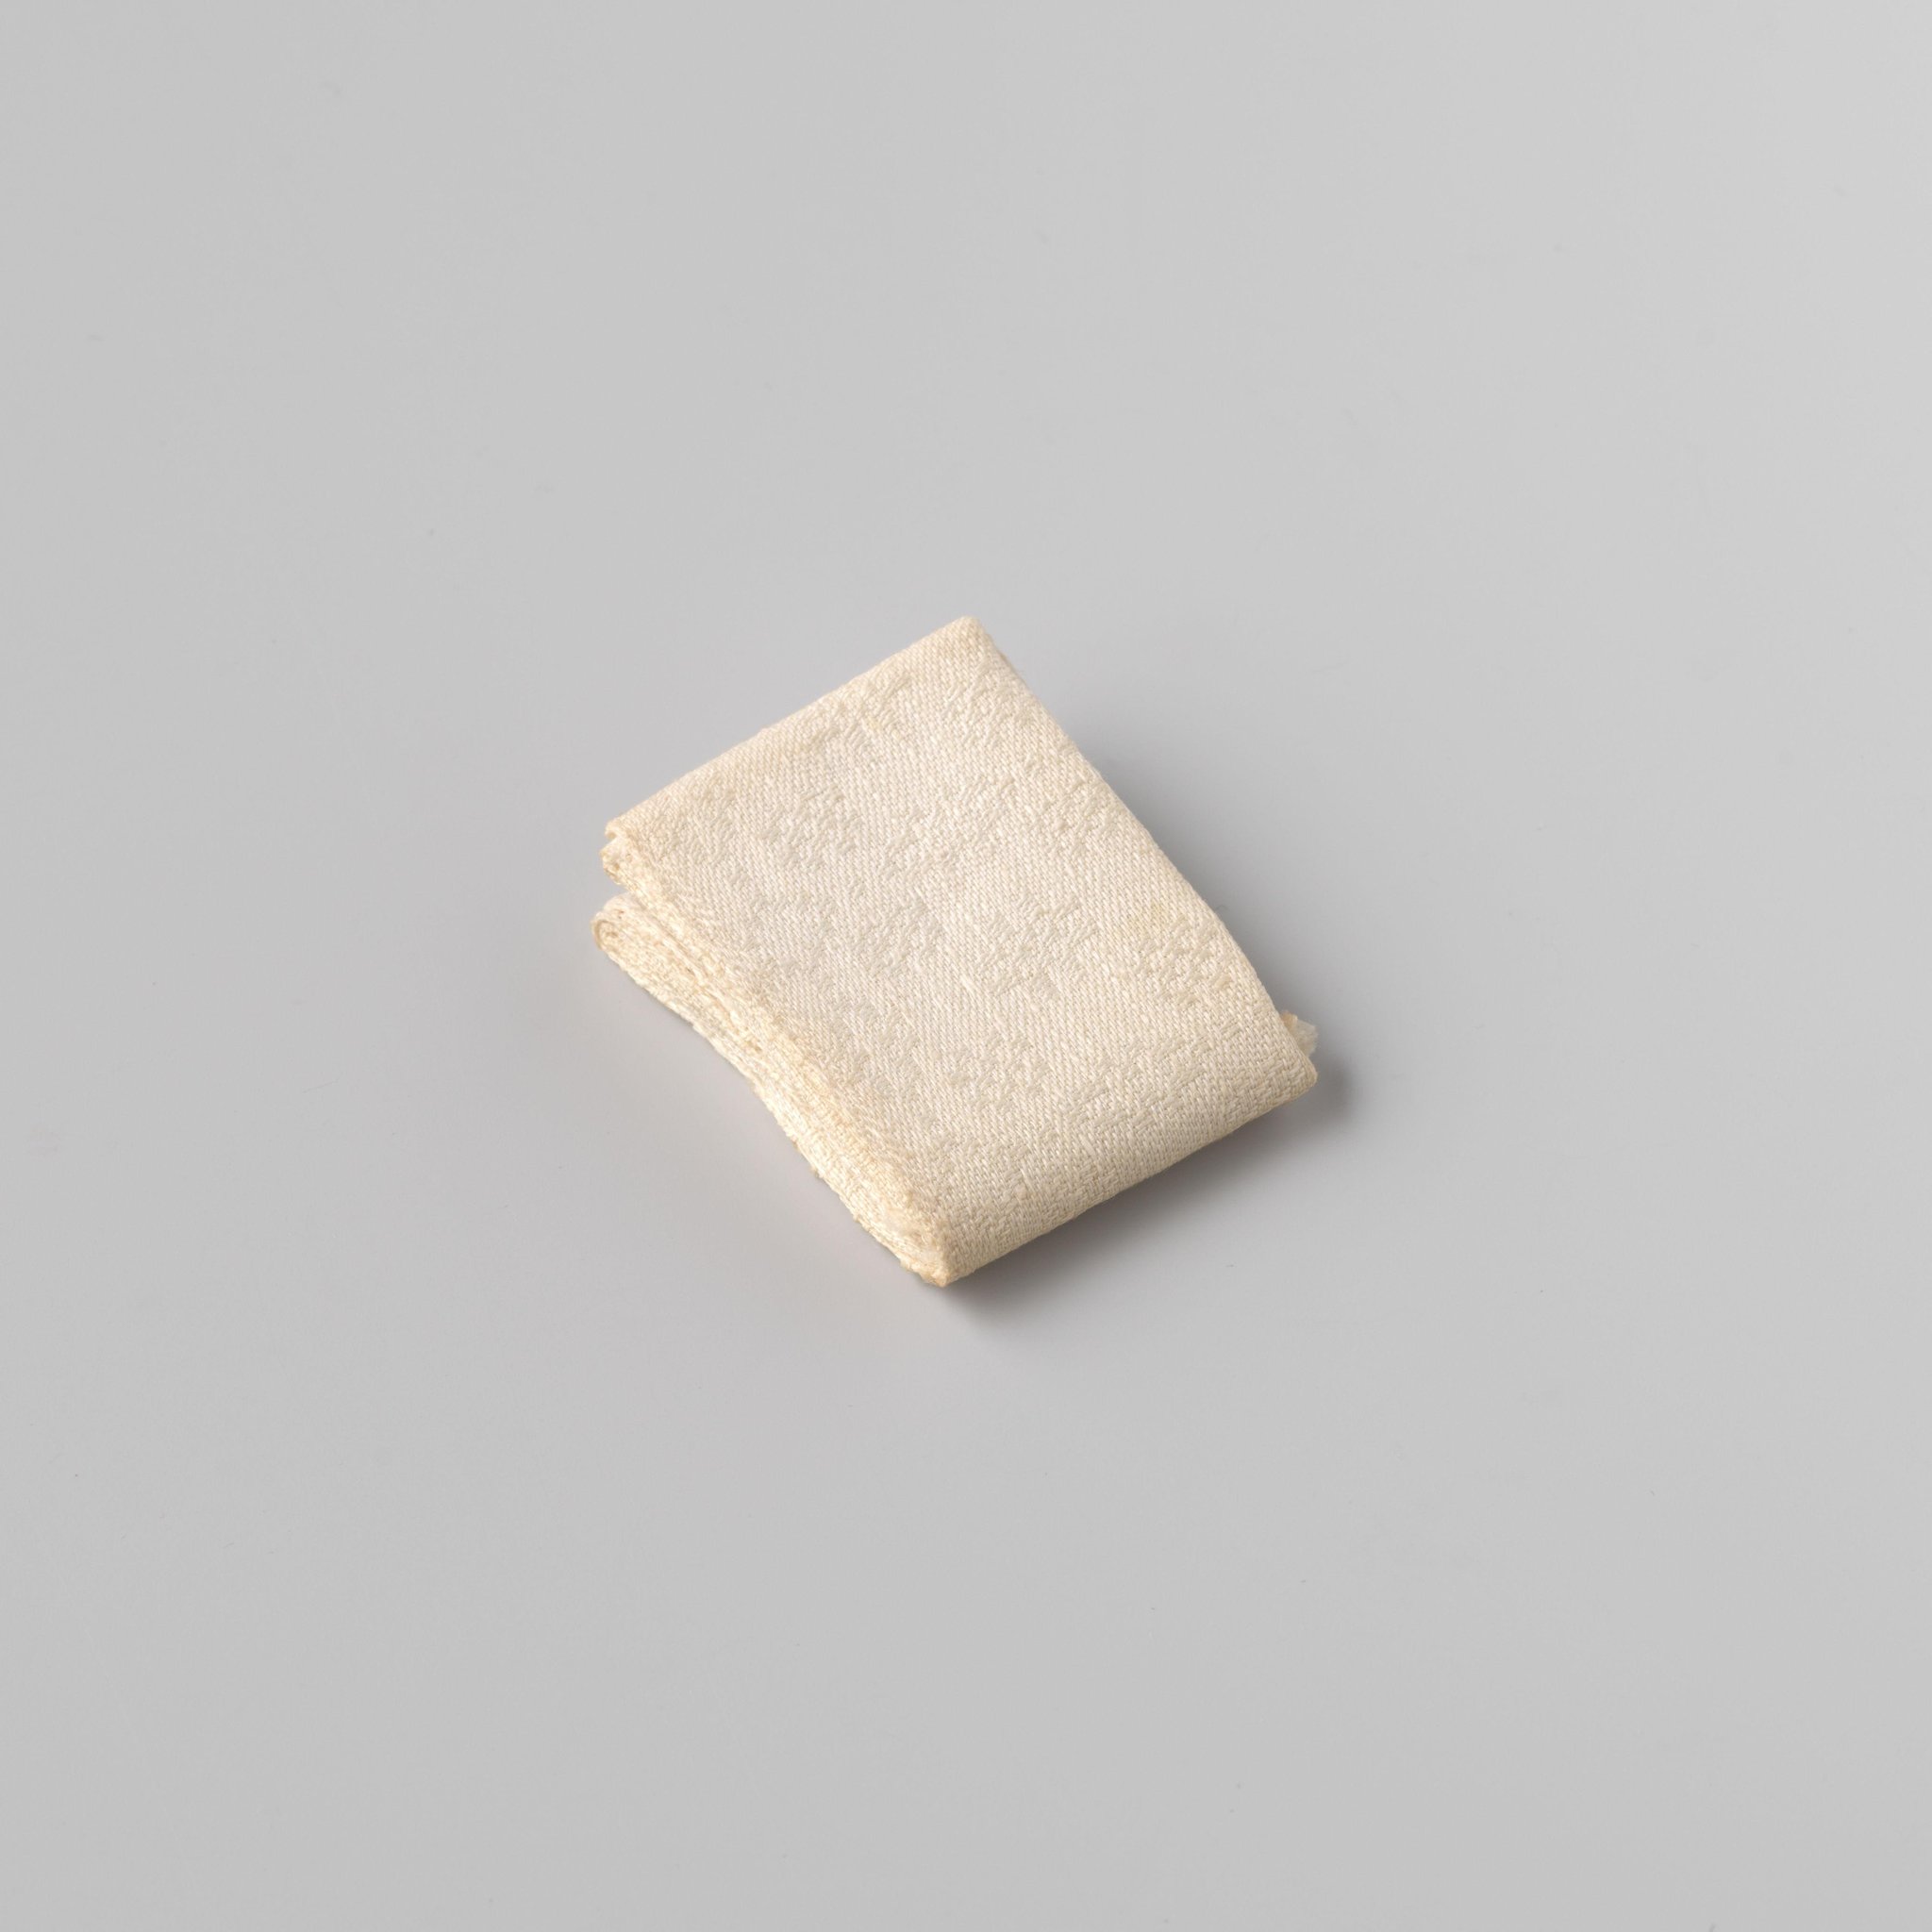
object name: napkin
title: Linnen servet van damastweefsel met pellenpatroon (motief I), geen zomen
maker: Anonymous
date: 1690-1710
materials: linen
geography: amsterdam